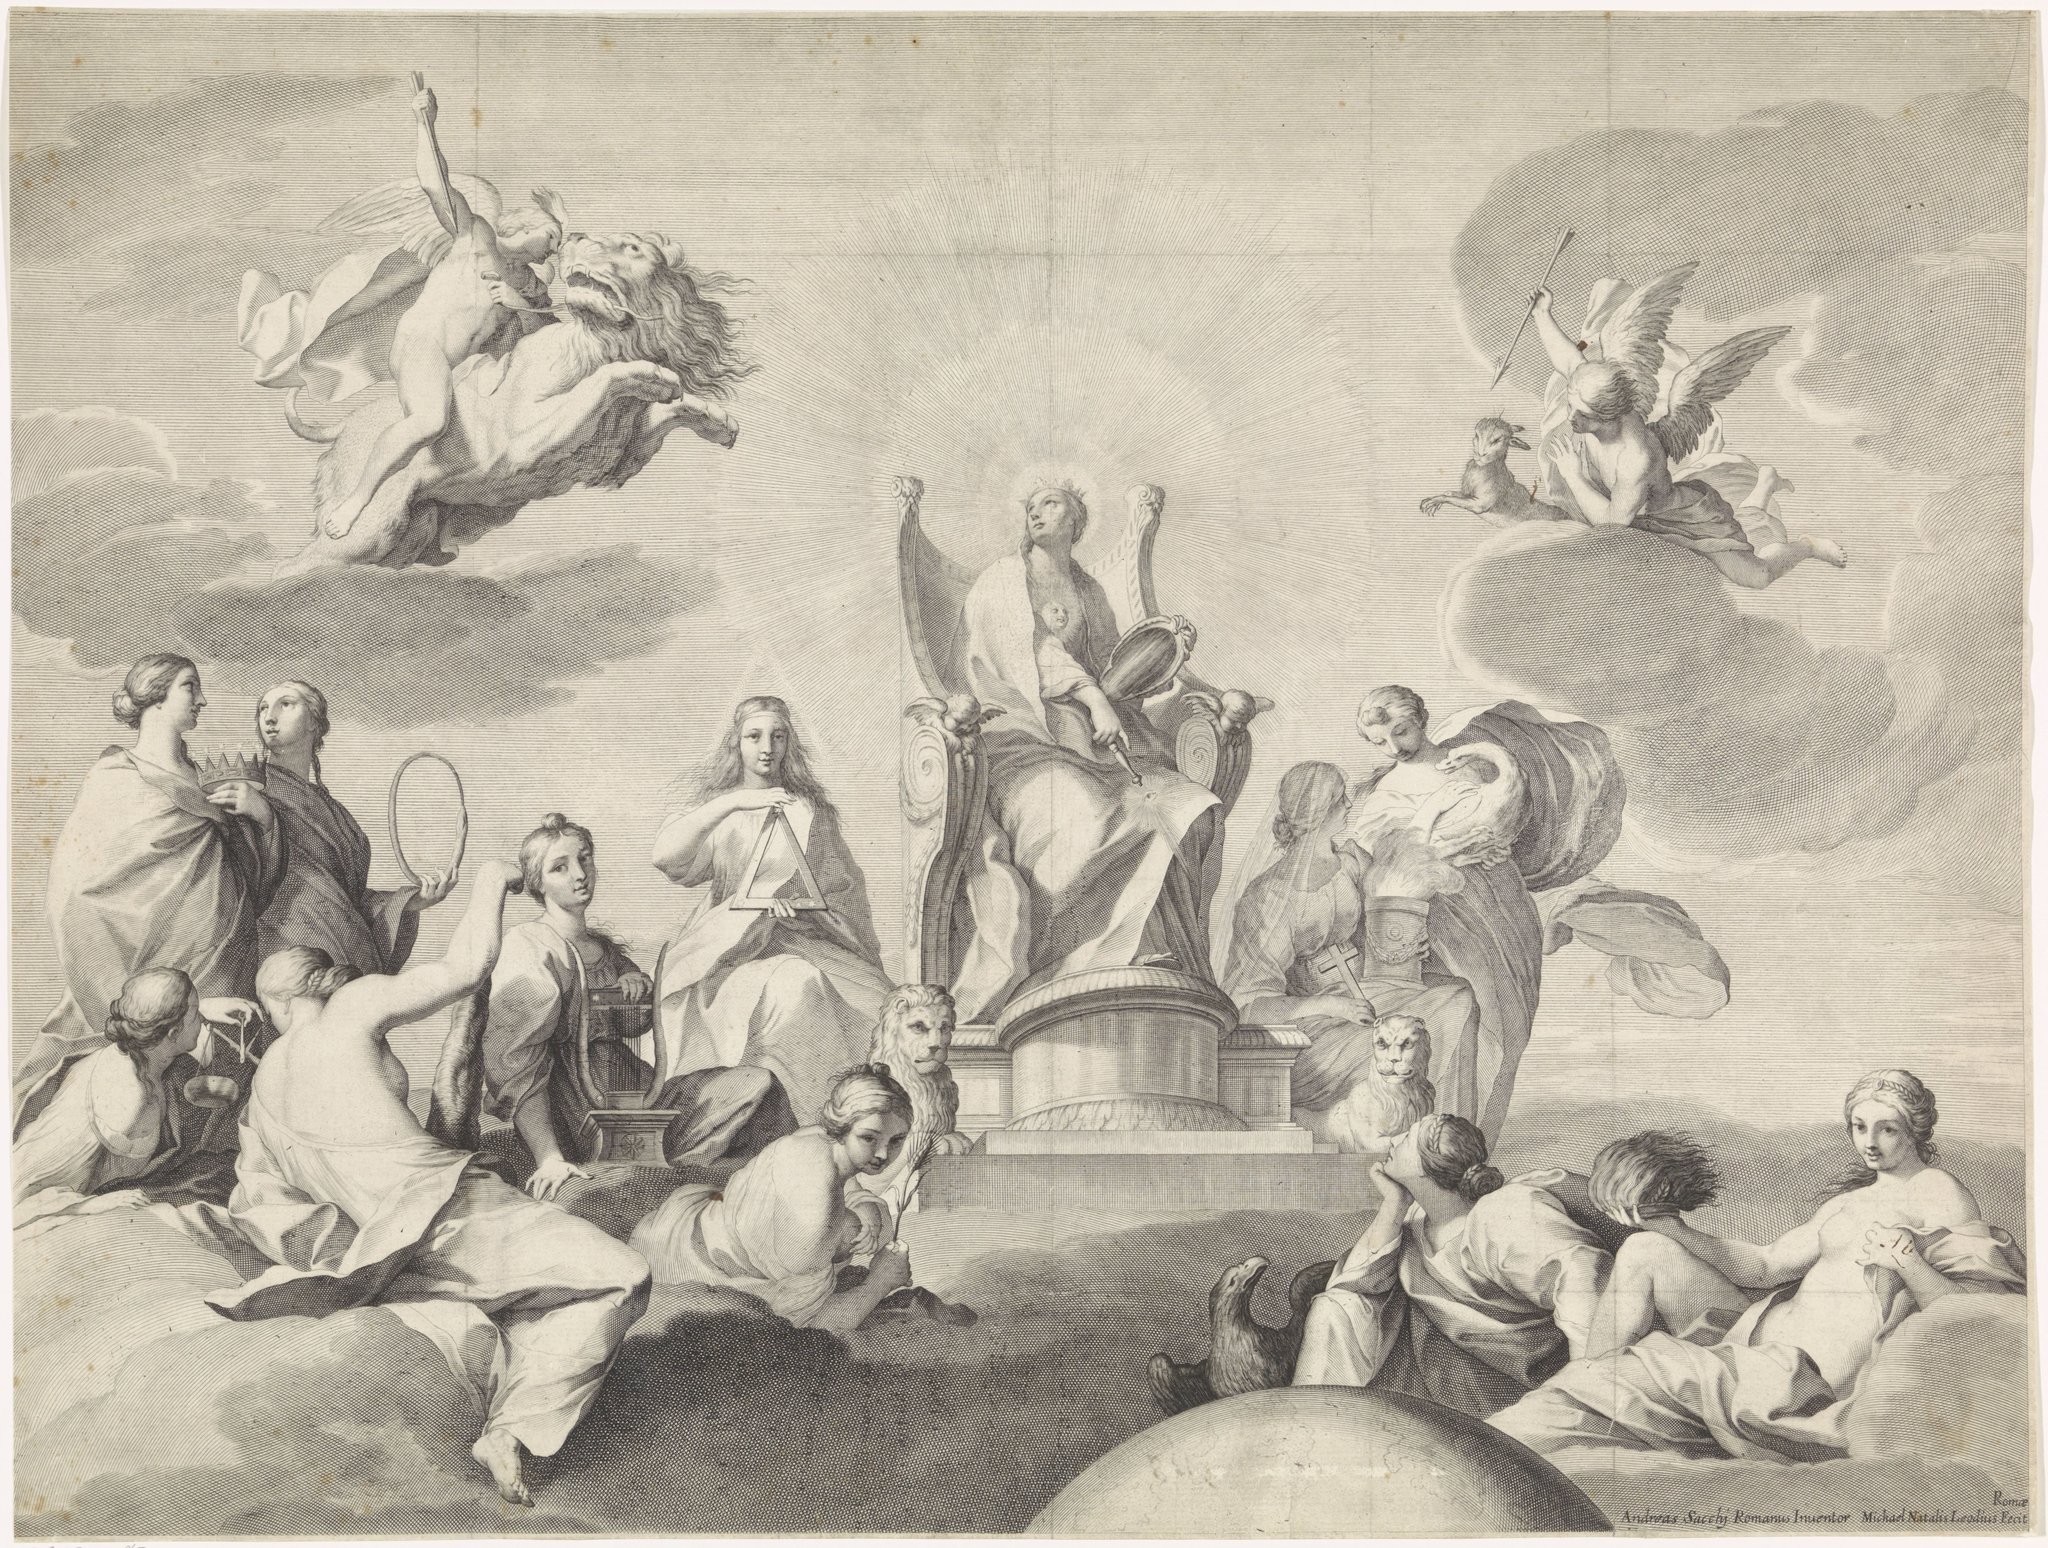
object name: print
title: Goddelijke voorzienigheid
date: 1620-1668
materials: paper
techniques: engraving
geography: rome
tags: justice, 'justitia'; 'giustitia divina' (ripa) ~ one of the four cardinal virtues, faith, 'fides'; 'fede', 'fede catholica', 'fede christiana', 'fede christiana catholica' (ripa) ~ one of the three theological virtues, forethought, deliberation; 'previdenza', 'providenza' (ripa)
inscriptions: collector's mark: Lugt 240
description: Te midden van andere vrouwelijke personificaties, zit Goddelijke Voorzienigheid op de troon, het hoofd gekroond en met stralenkrans, een zon op haar borst. Zij wijst met een aanwijsstok met daaronder het oog, symbool van God de Vader, naar de aarde. Om de troon op de wolken zitten vrouwelijke personificaties, waaronder de Rechtvaardigheid met weegschaal, Eeuwigheid met een cirkelvormige slang, Geloof met kruis, Wijsheid met driehoek, Vruchtbaarheid met korenaar. Ook te zien zijn een vrouw met kroon, een vrouw met harp, een vrouw met zwaan en een vrouw met adelaar. Linksboven een engel met pijl in de hand op de rug van een leeuw. Linksboven een engel met pijl in de hand op de rug van een haas.